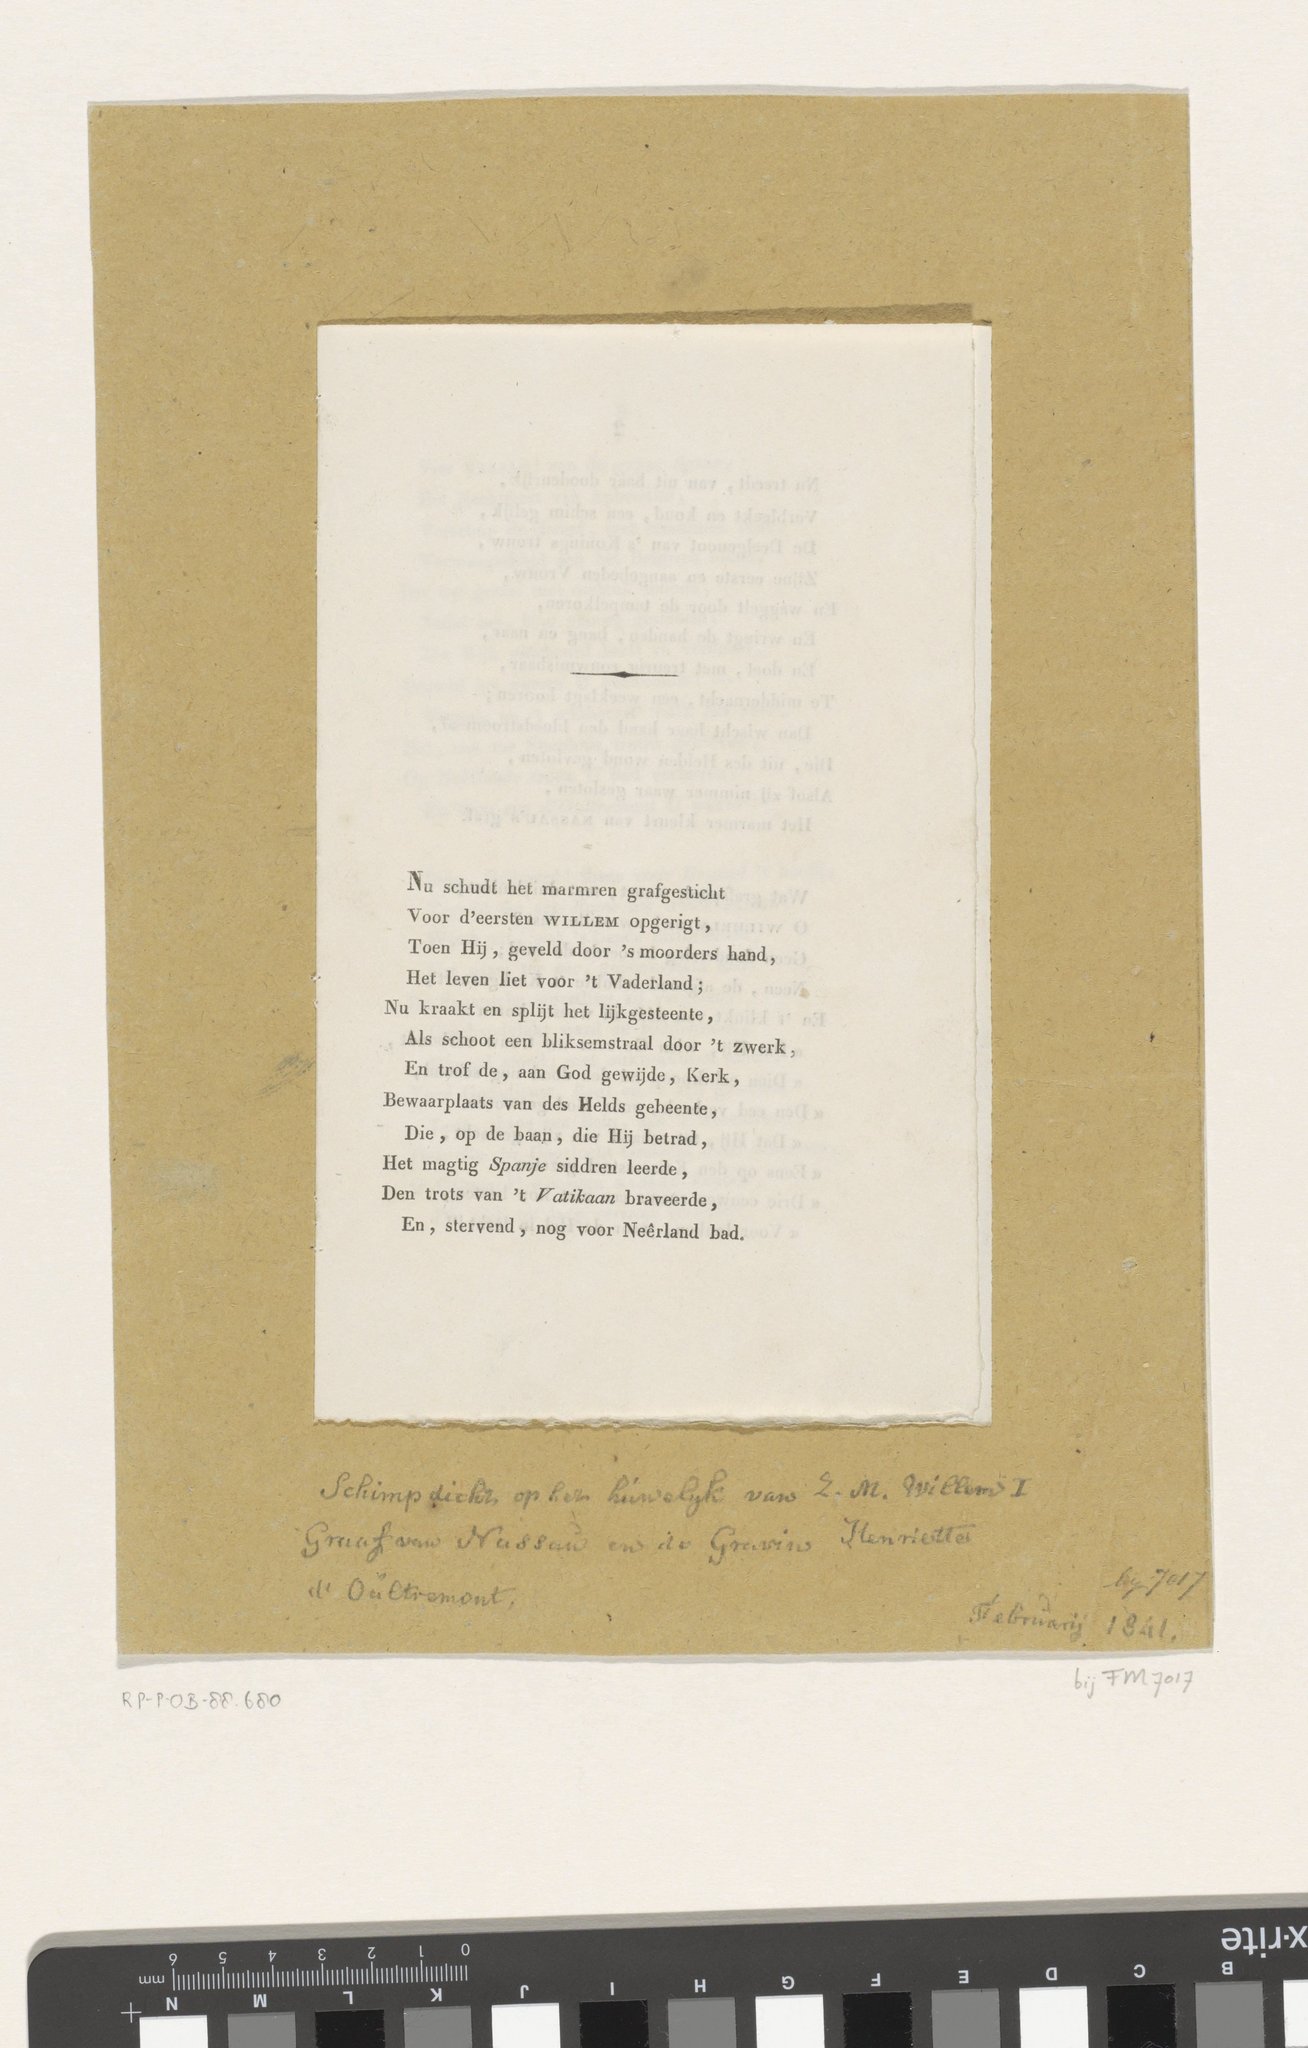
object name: poem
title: Schimpdicht op het voorgenomen huwelijk van de voormalige koning Willem I, 1840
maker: Anonymous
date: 1840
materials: paper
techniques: letterpress printing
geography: netherlands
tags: the hague, berlin, william i of the netherlands, maastricht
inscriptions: collector's mark: Lugt 2228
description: Gedrukt schimpdicht op het voorgenomen huwelijk van de voormalige koning Willem I met de katholieke H.R. rijksgravin Henriëtte d'Oultremont de Wégimont, 1840. Dubbelgevouwen blad bedrukt op alle vier (genummerde) bladzijden.